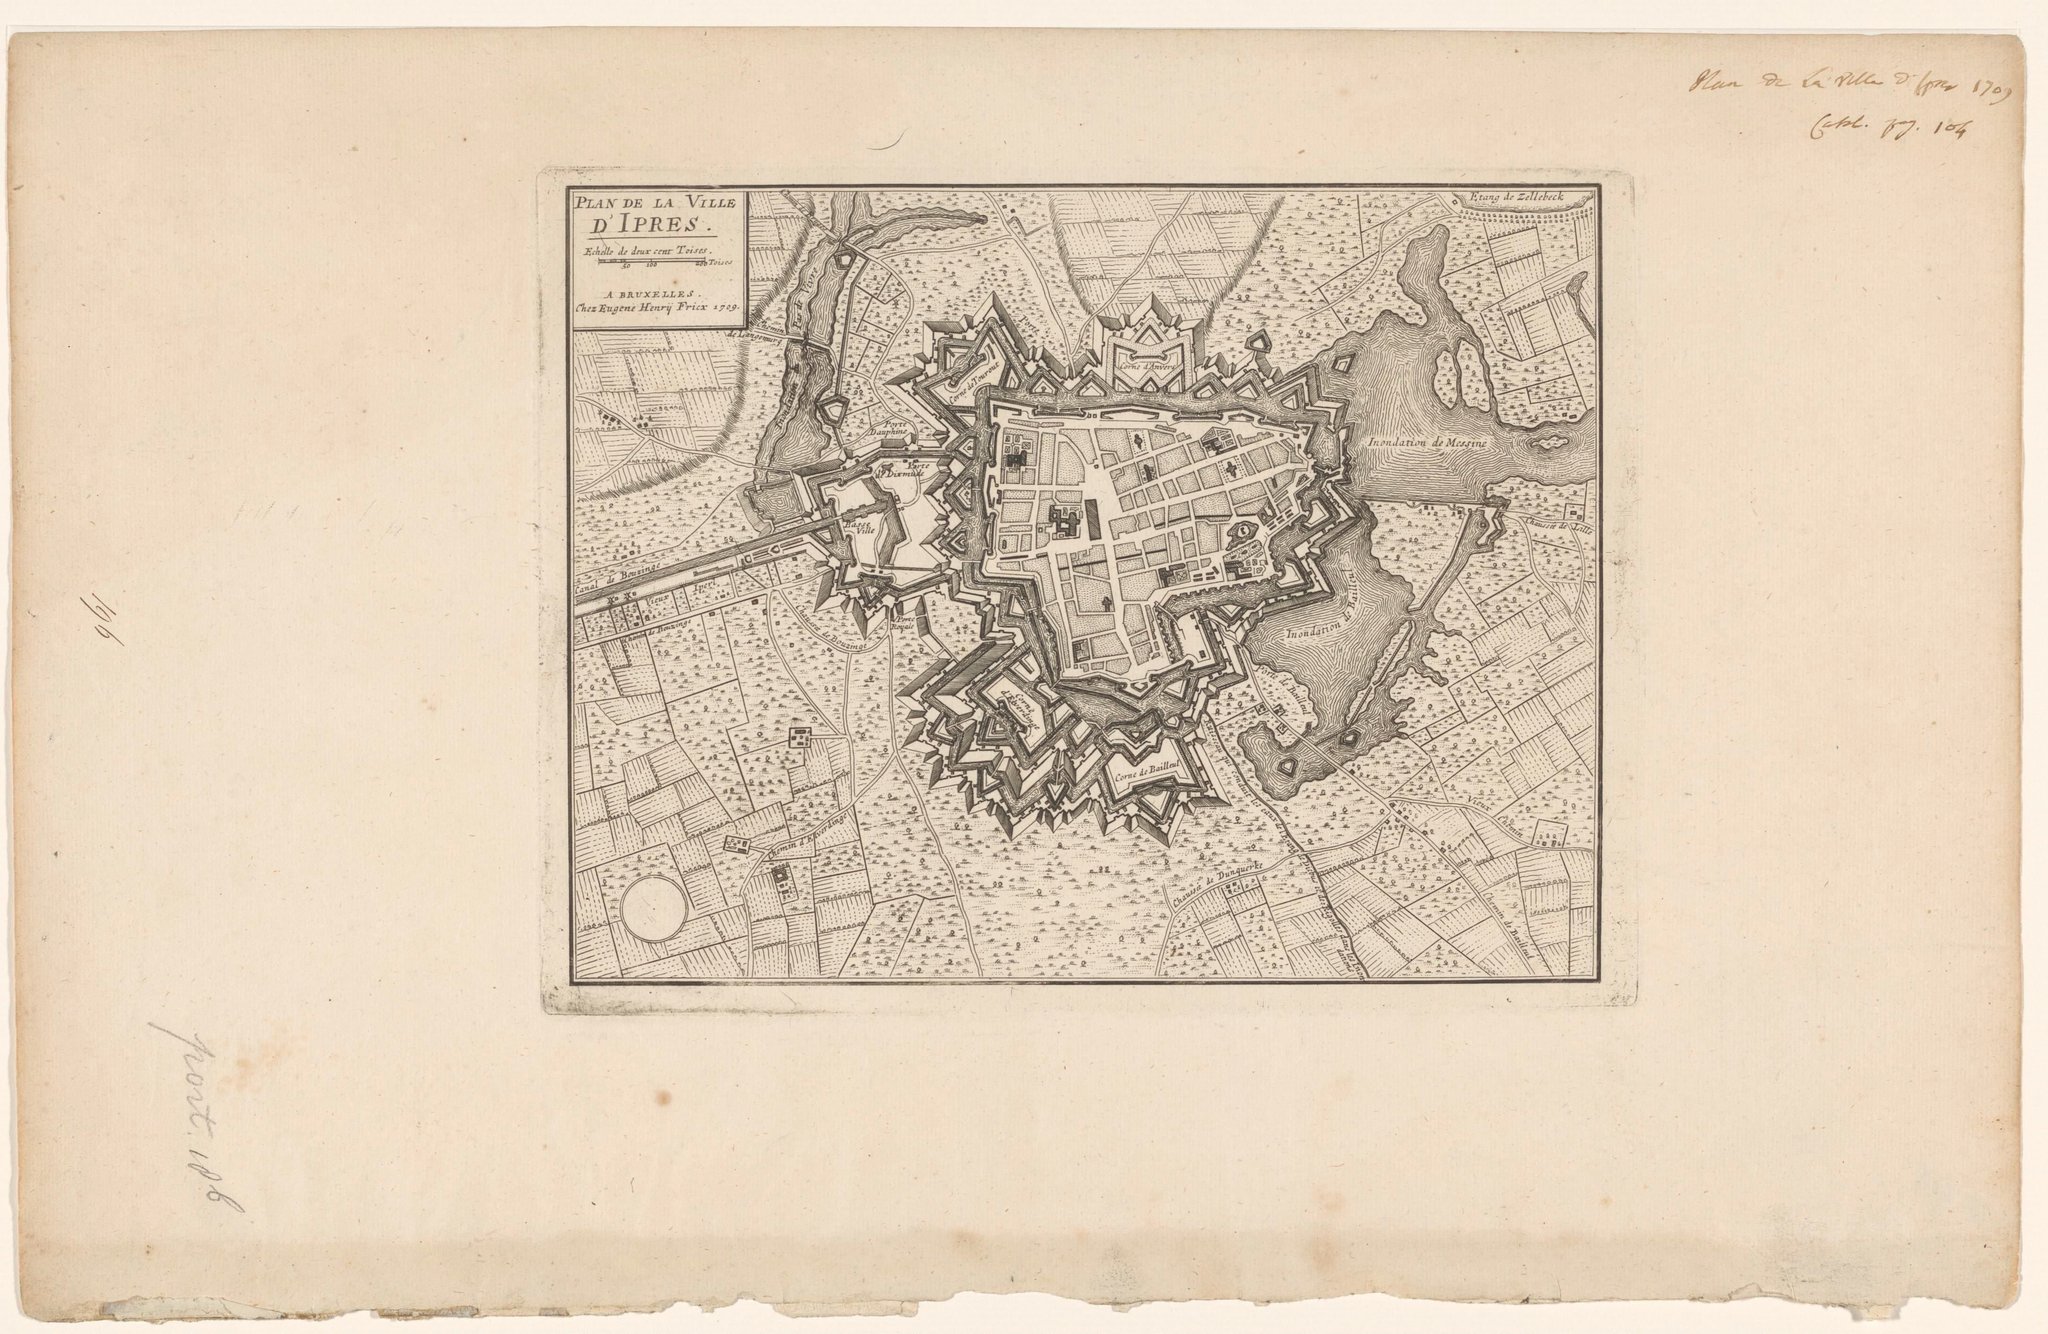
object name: area plan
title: Plan de la ville d'Ipres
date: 1709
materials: paper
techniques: etching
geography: brussels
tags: maps of cities